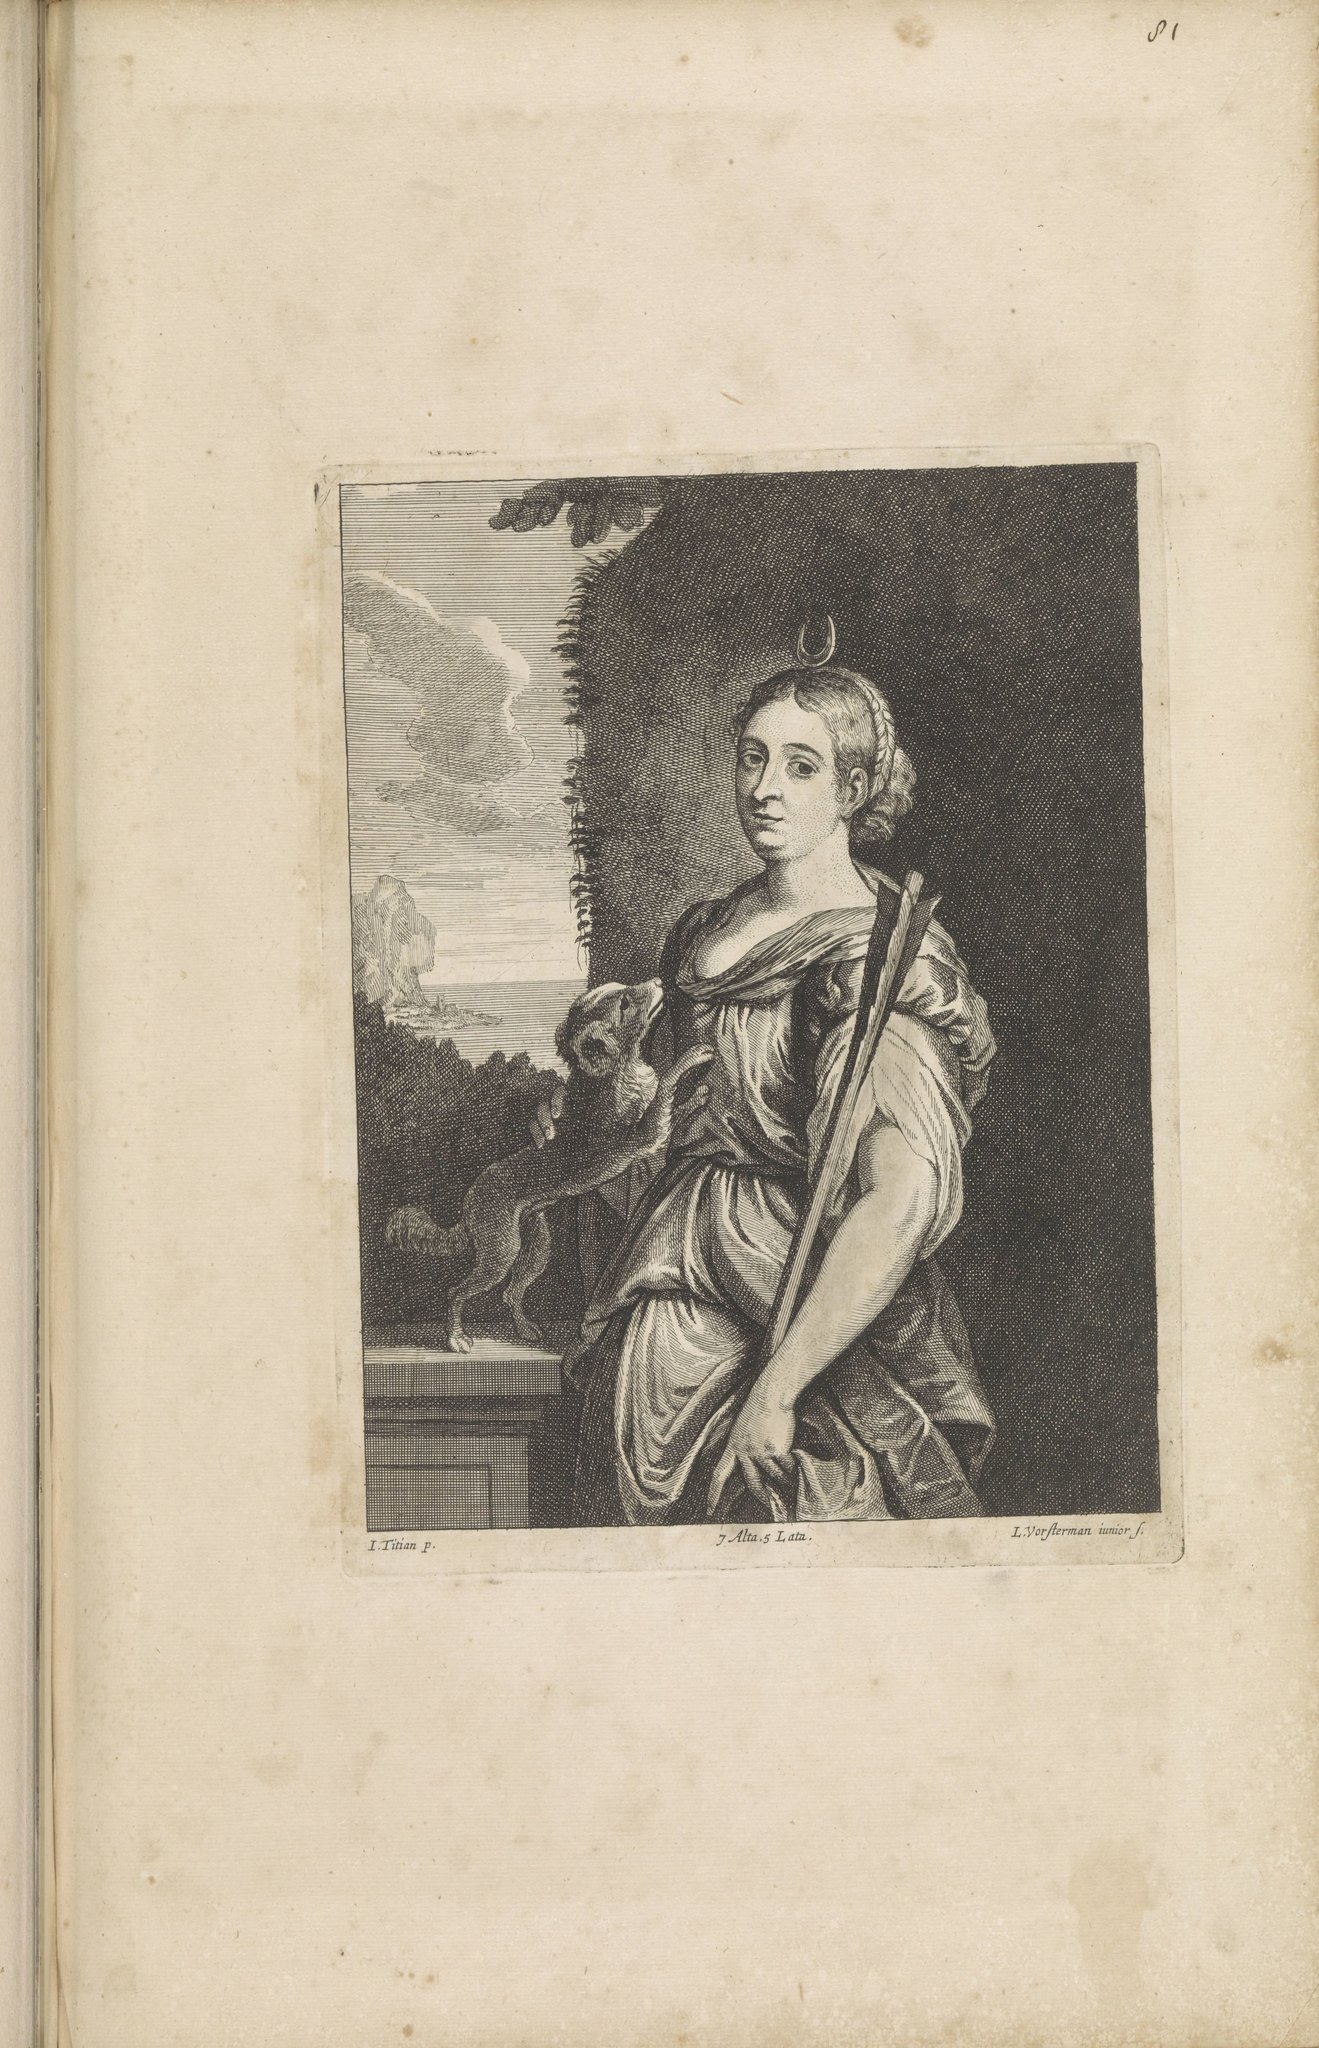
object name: album leaf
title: Diana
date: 1660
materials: paper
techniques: engraving, etching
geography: brussels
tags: (story of) diana (artemis), landscapes in the temperate zone, dog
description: David Teniers heeft waarschijnlijk van alle schilderijen uit de collectie van Leopold Willem van Oostenrijk een olieverfstudie op doek of paneel vervaardigd (zgn. pasticcio), die als voorbeeld voor de prentmakers diende. Het is niet altijd duidelijk of de pasticci door hem zijn gemaakt of door zijn atelier. Niet alle pasticci zijn overgeleverd.